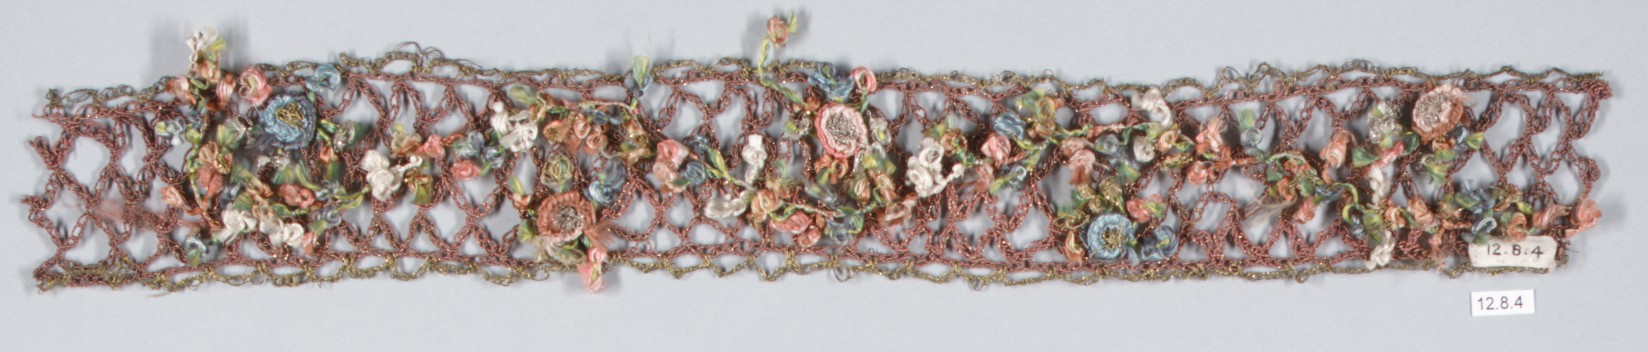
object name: passementerie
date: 1701-1800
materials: silk